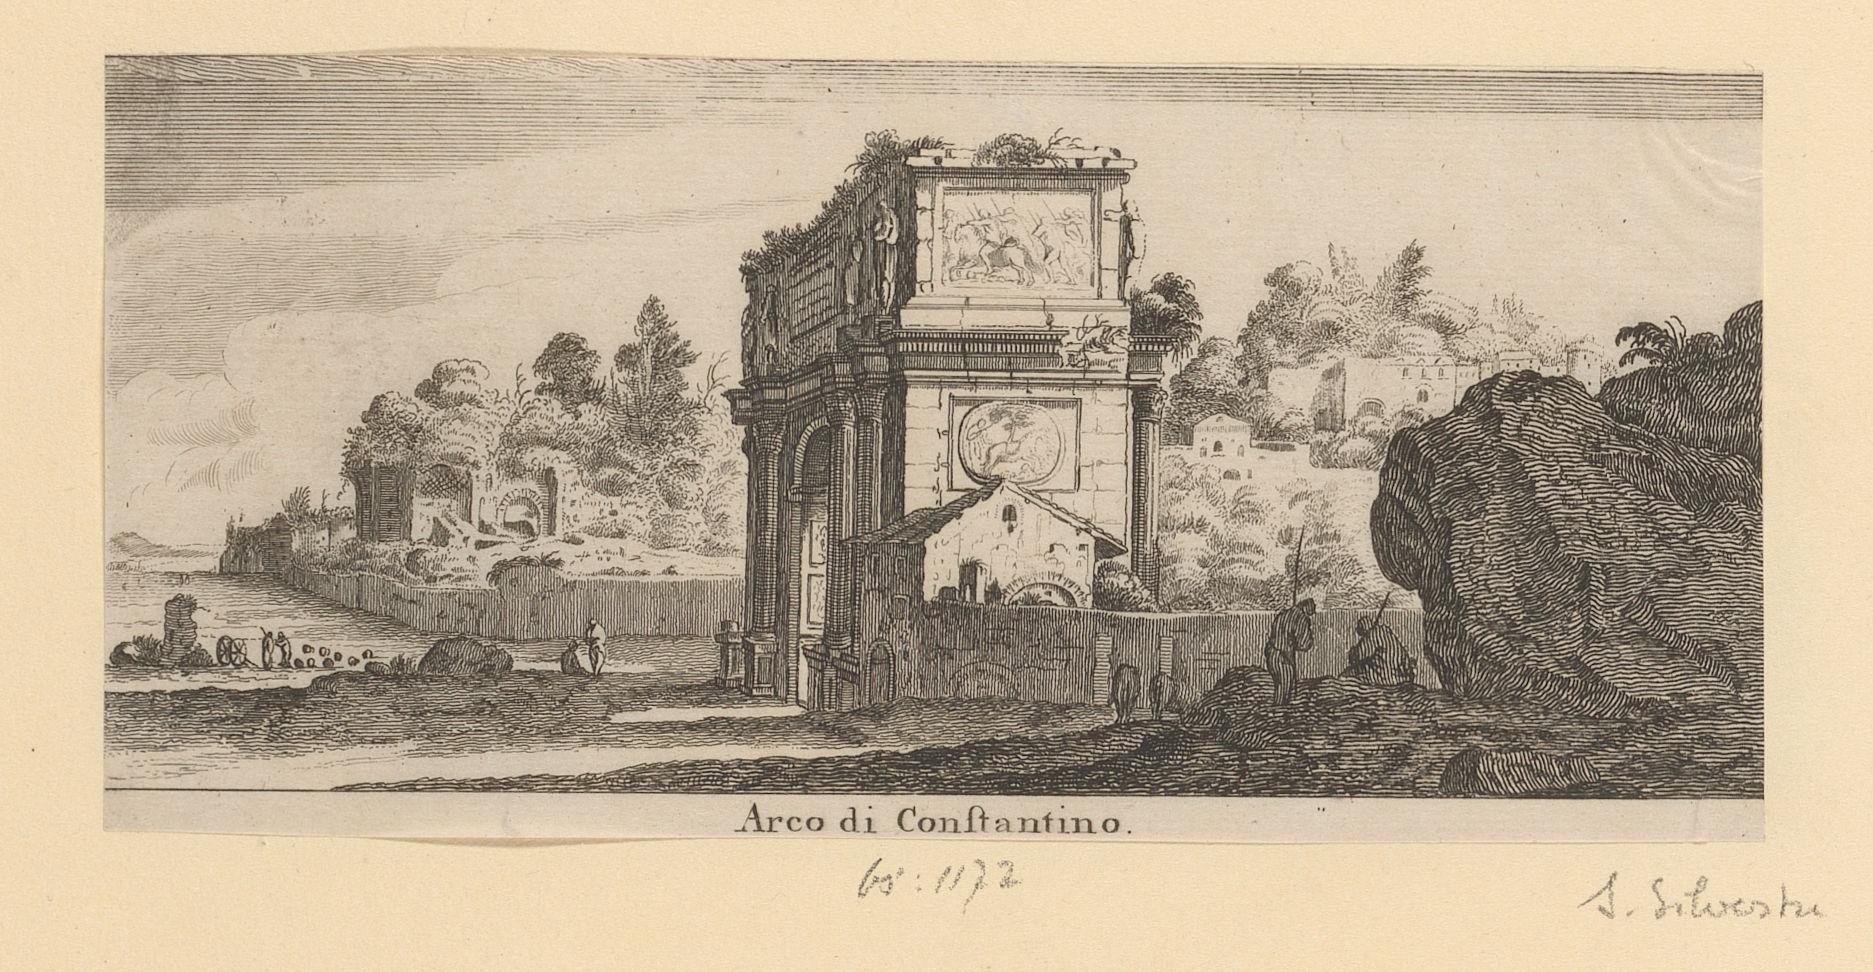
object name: album leaf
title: Arco di Constantino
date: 1638-1799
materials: paper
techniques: etching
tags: landscape with ruins (+ city(-scape) with figures, staffage), arch of constantine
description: Prent maakt mogelijk deel uit van een serie van 200 prenten. Deze serie is onder de titel 'A Collection of two hundred original etchings' voor het eerst uitgegeven door J.M. Greery in 1816.